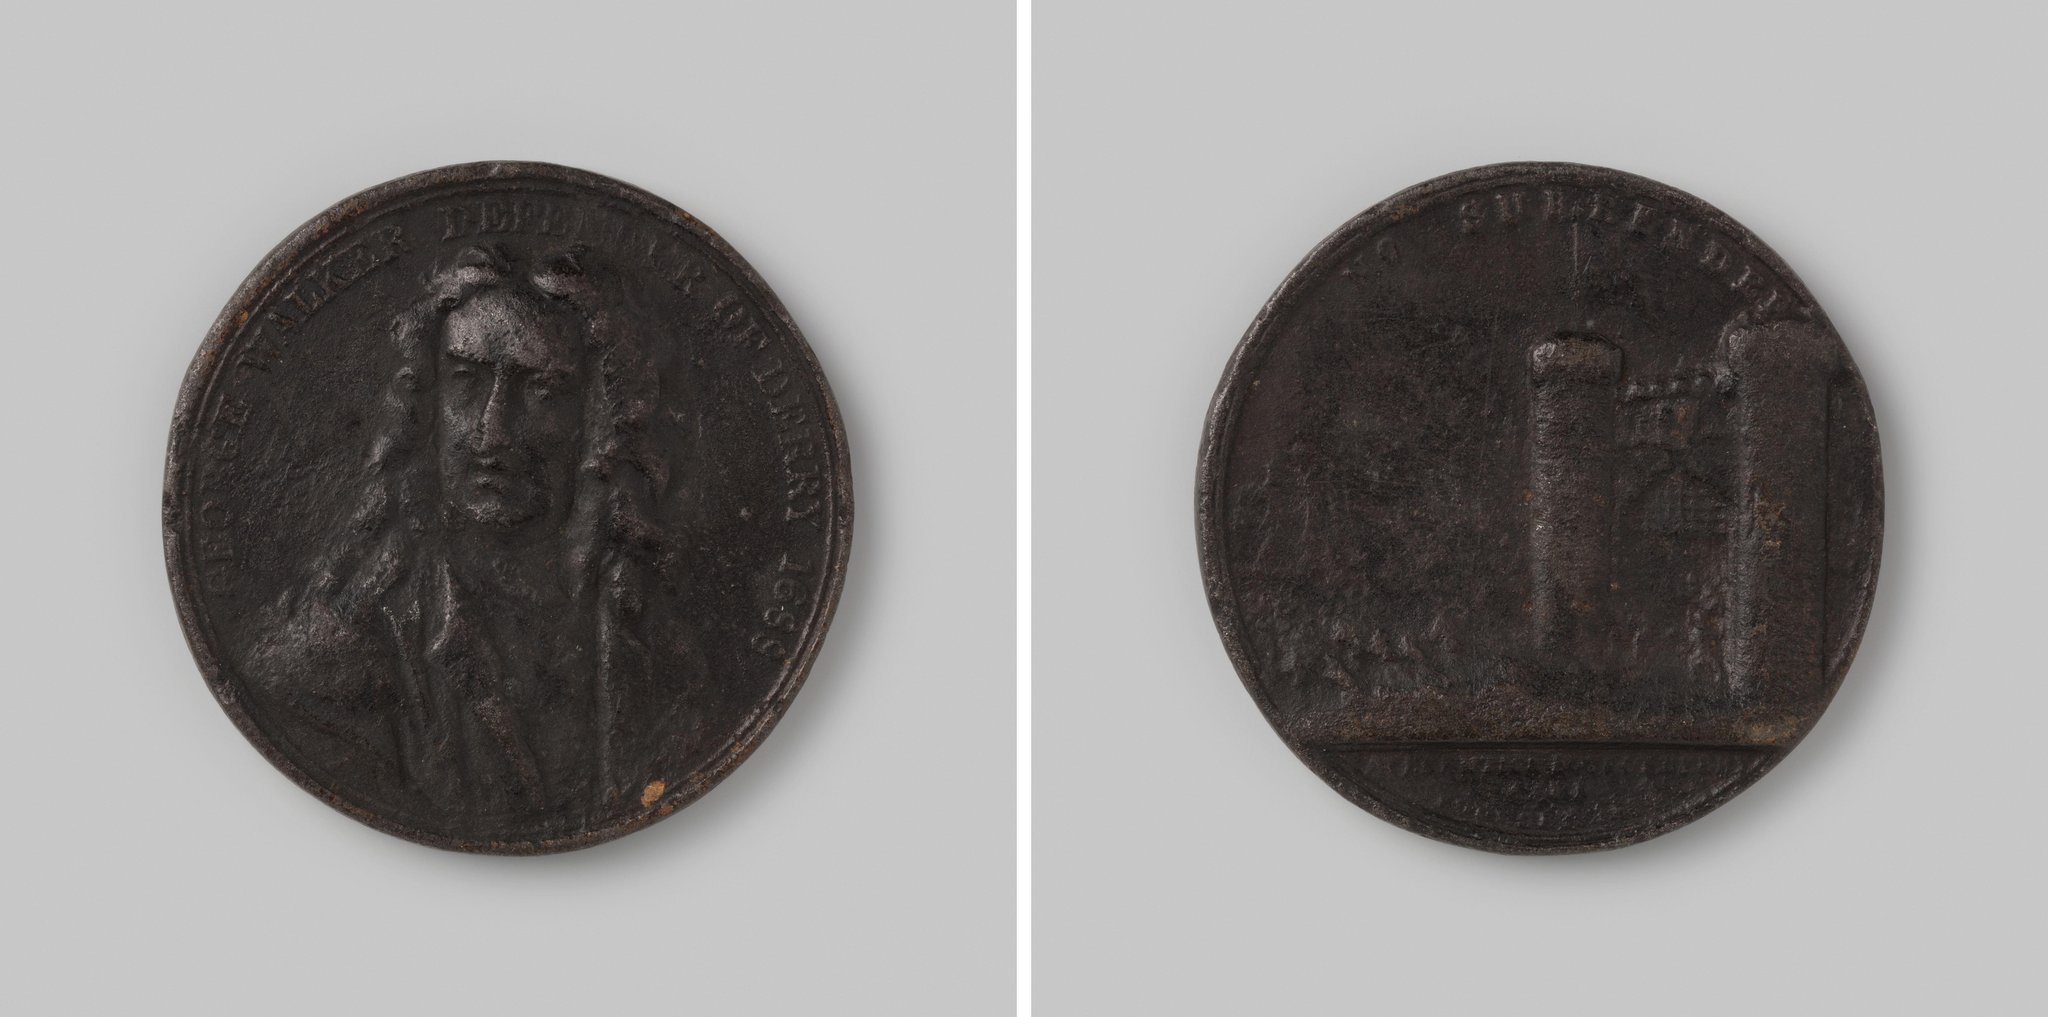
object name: history medal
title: Verdediging van Derby onder George Walker 1689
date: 1689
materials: iron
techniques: casting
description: IJzeren afgietsel van een penning, op de voorzijde het borstbeeld van Walker, met omschrift, op de keerzijde de aanval op een stadspoort waarboven NO SURRENDER en afsnedetekst.